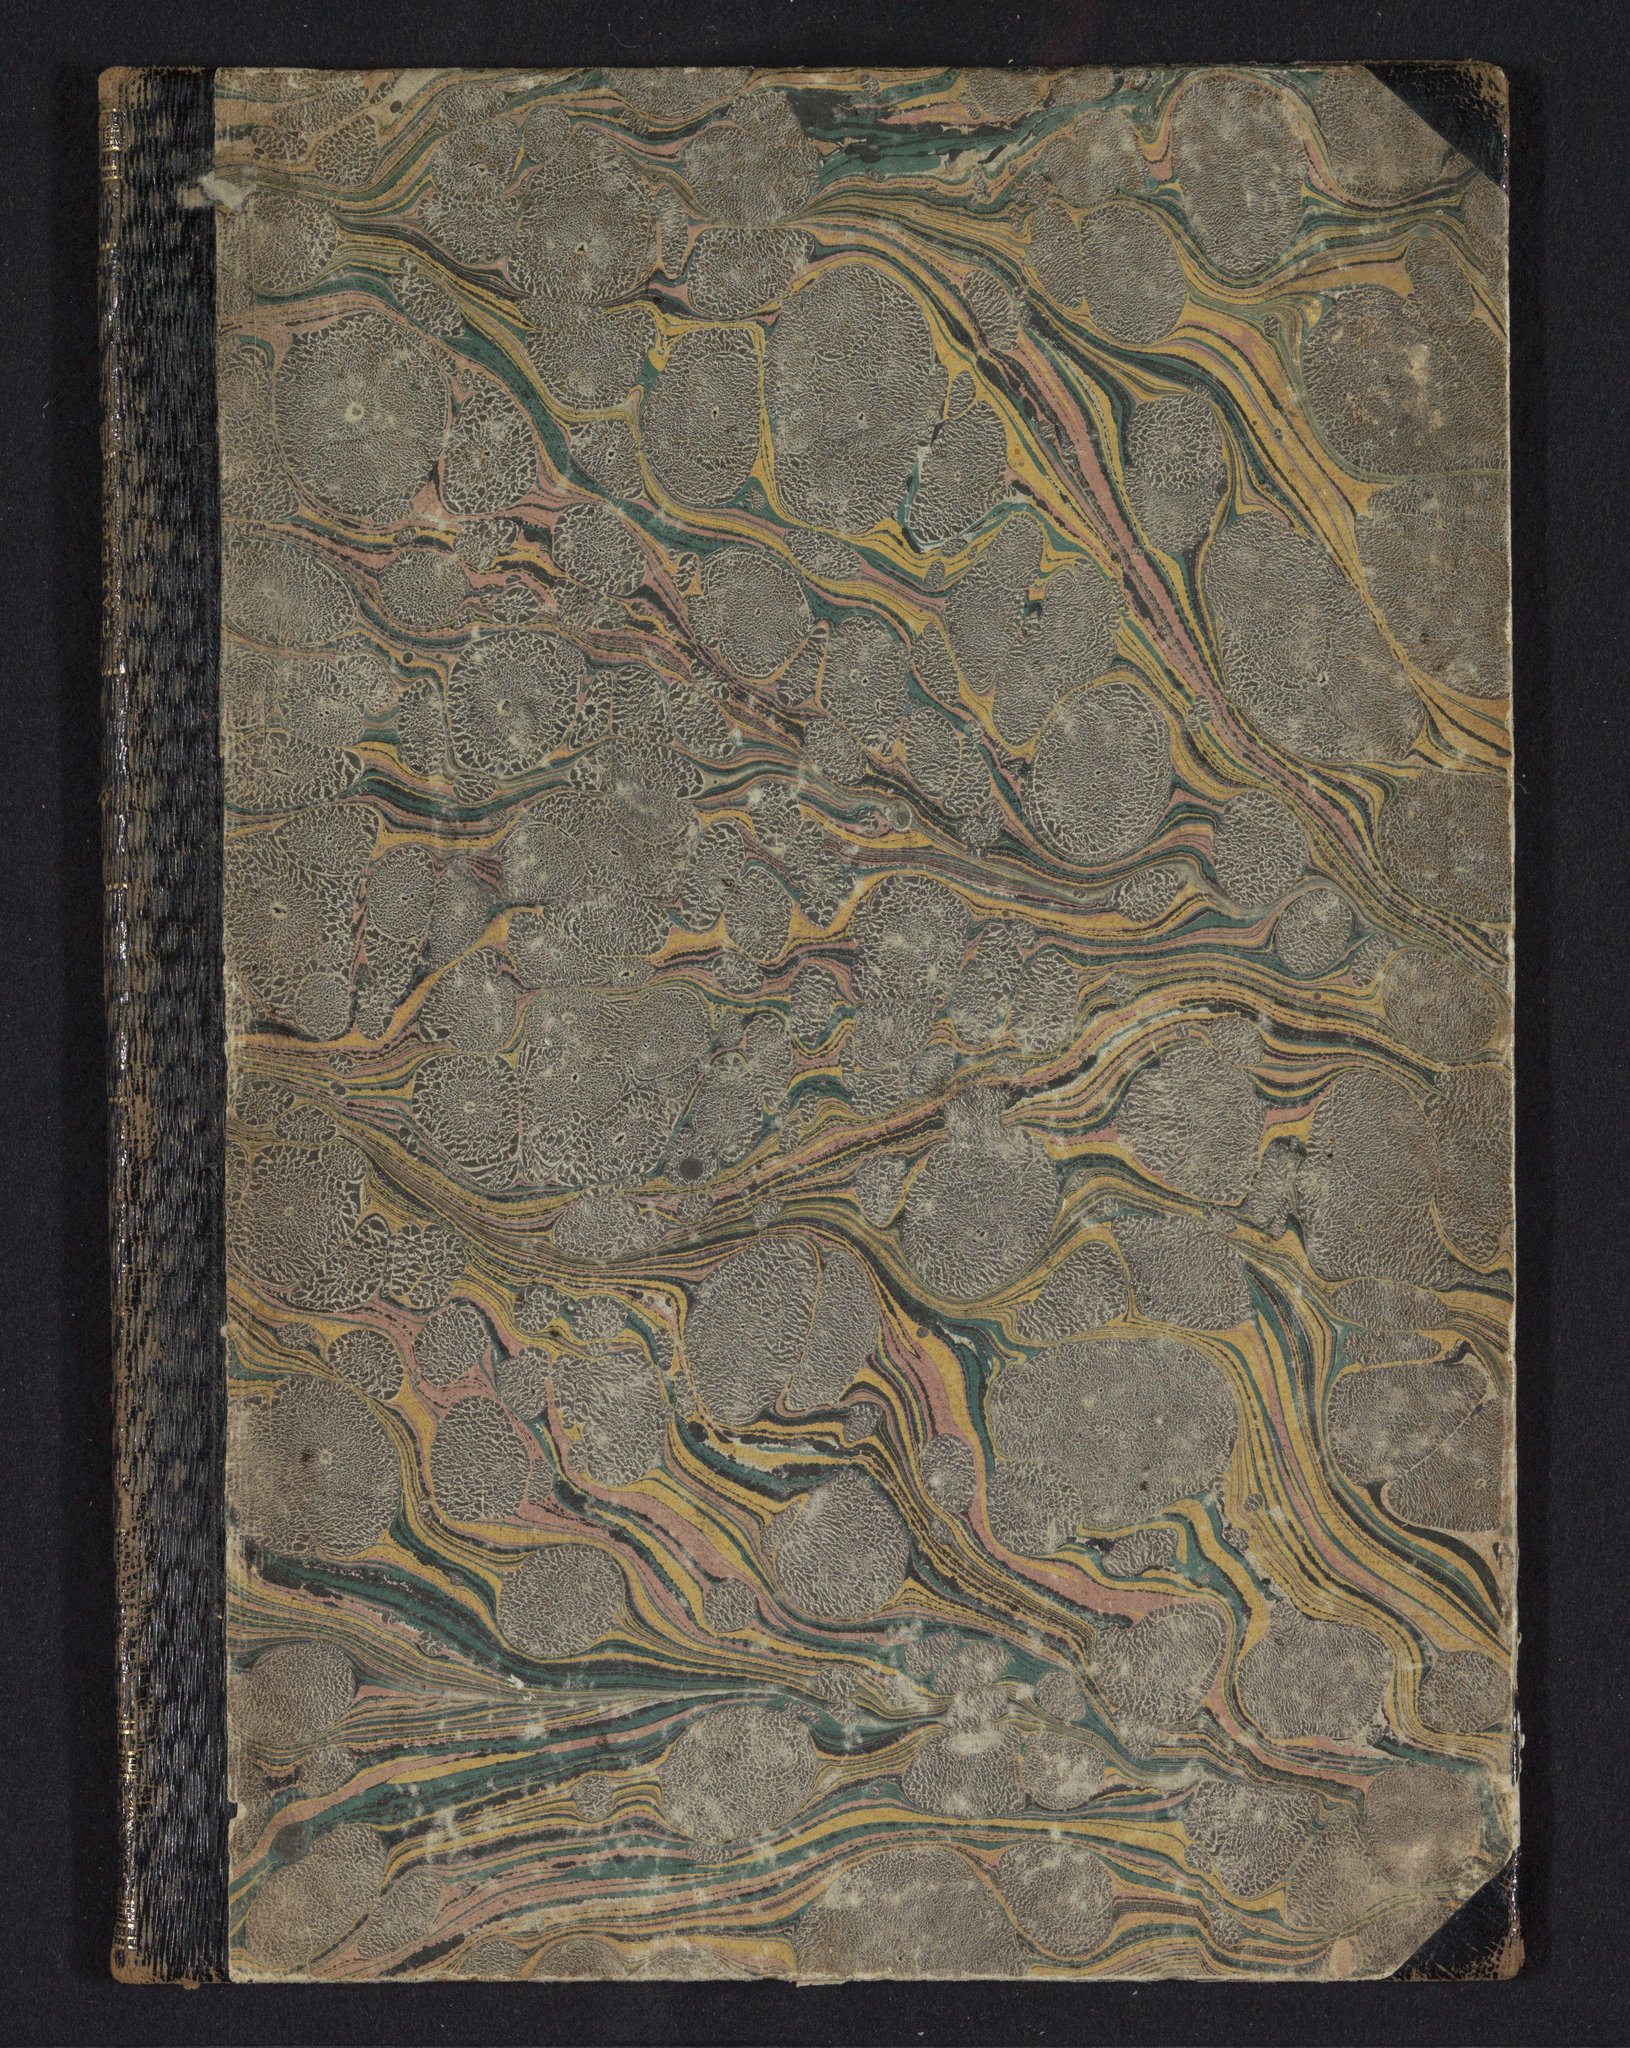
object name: prentrecueil, prentenalbum, prentalbum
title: Prentalbum met zeven prenten, voorstellende de zeven bloedstortingen van Christus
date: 1580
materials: cardboard, leather, paper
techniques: engraving, marbling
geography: antwerp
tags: the seven bleedings of christ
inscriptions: inscription: ‘GALLEUS’, bookplate: ‘EX LIBRIS SILVII ZIPOLI / Casella 2’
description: Prentalbum met zeven prenten, voorstellende de zeven bloedstortingen (of bloedingen) van Christus in zeven ronde gravures met randschriften.